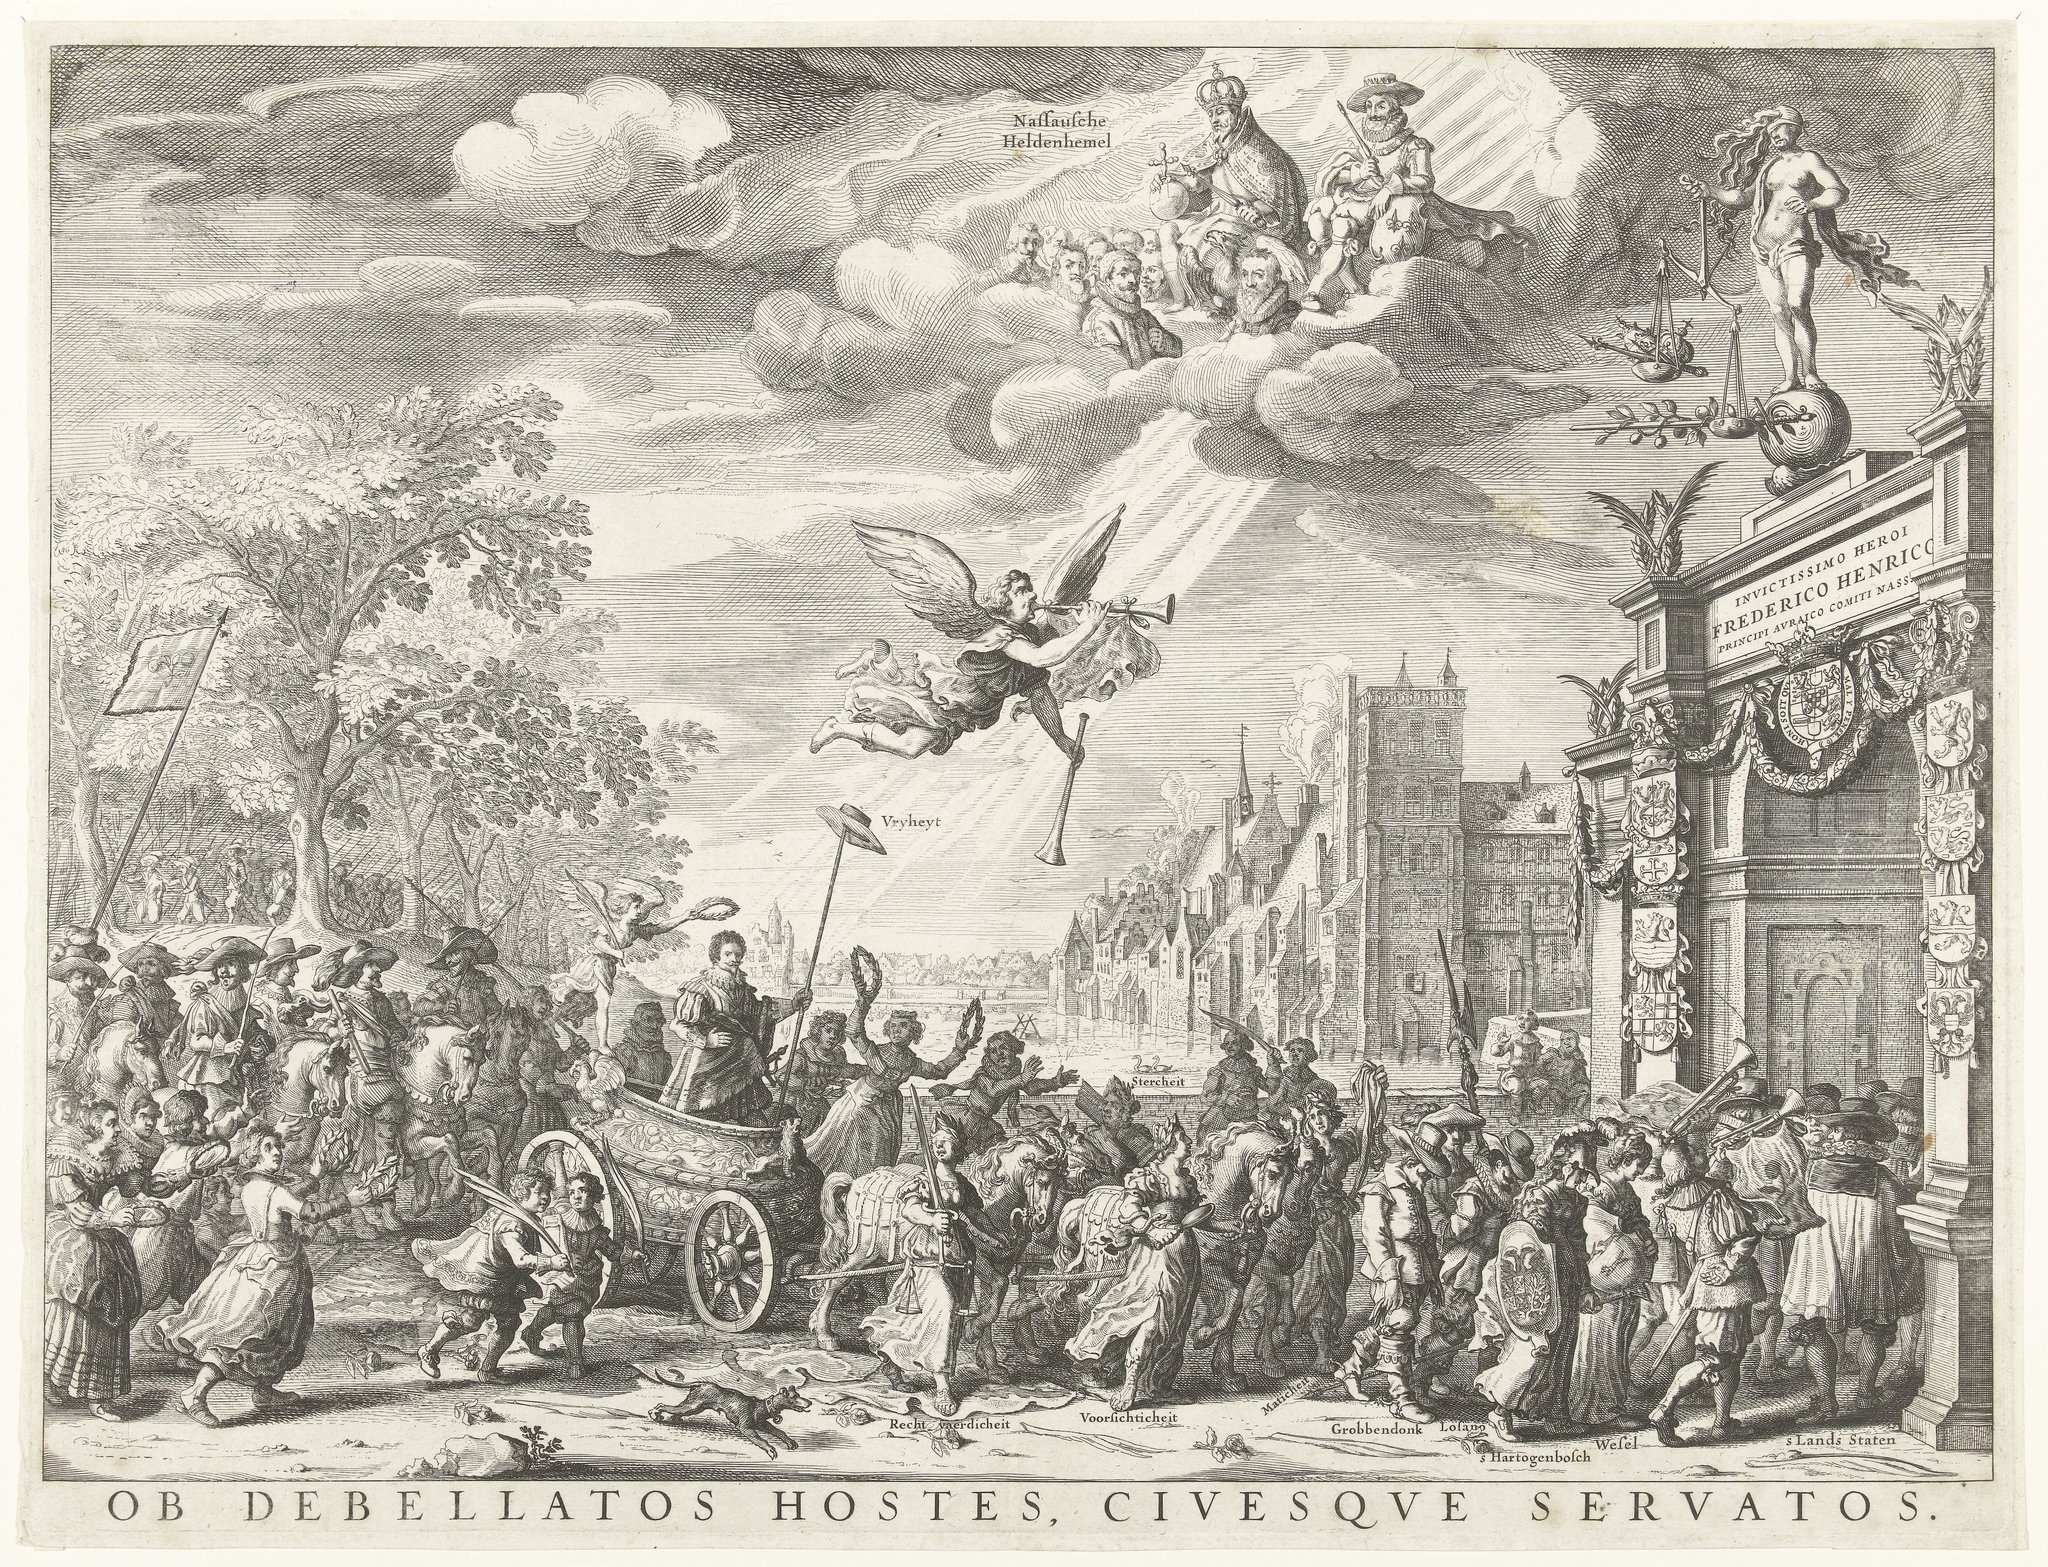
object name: propagandaprent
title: Ob debellatos hostes, civesque servatos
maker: salomon savery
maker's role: print maker, publisher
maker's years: 1594-1683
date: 1629-1630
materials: paper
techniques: engraving, etching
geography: northern netherlands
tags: johan van oldenbarnevelt, frederick henry (prince of orange), delft, william i (prince of orange), maurice (prince of orange), antwerp, brussels, anthonie schets baron van grobbendonck, hendrik iv (koning van frankrijk en navarra), 'sapientia' and the seven virtues, i.e. the three theological and the four cardinal virtues, symbolic triumphs of individual persons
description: Allegorie ter ere van de veroveringen van Den Bosch en Wesel door Frederik Hendrik in 1629, uitgebeeld in een allegorische triomfantelijke intocht in Den Haag. De stadhouder staat met vrijheidslans in een strijdwagen en wordt gekroond door Overwinning. De paarden voor de wagen worden geflankeerd door de deugden Rechtvaardigheid (Justitia), Kracht (Fortitudo), Matigheid (Temperantia) en Voorzichtigheid (Prudentia). Voor de wagen uit lopen de leden van de Staten-Generaal, verslagen Spanjaarden en stedenmaagden van Den Bosch en Wesel. In de lucht de Faam en de Nassausche Heldenhemel met Willem van Oranje, Maurits, de Duitse keizer, de Franse koning Hendrik IV en Johan van Oldenbarnevelt. Op de achtergrond het Binnenhof en de Hofvijver.